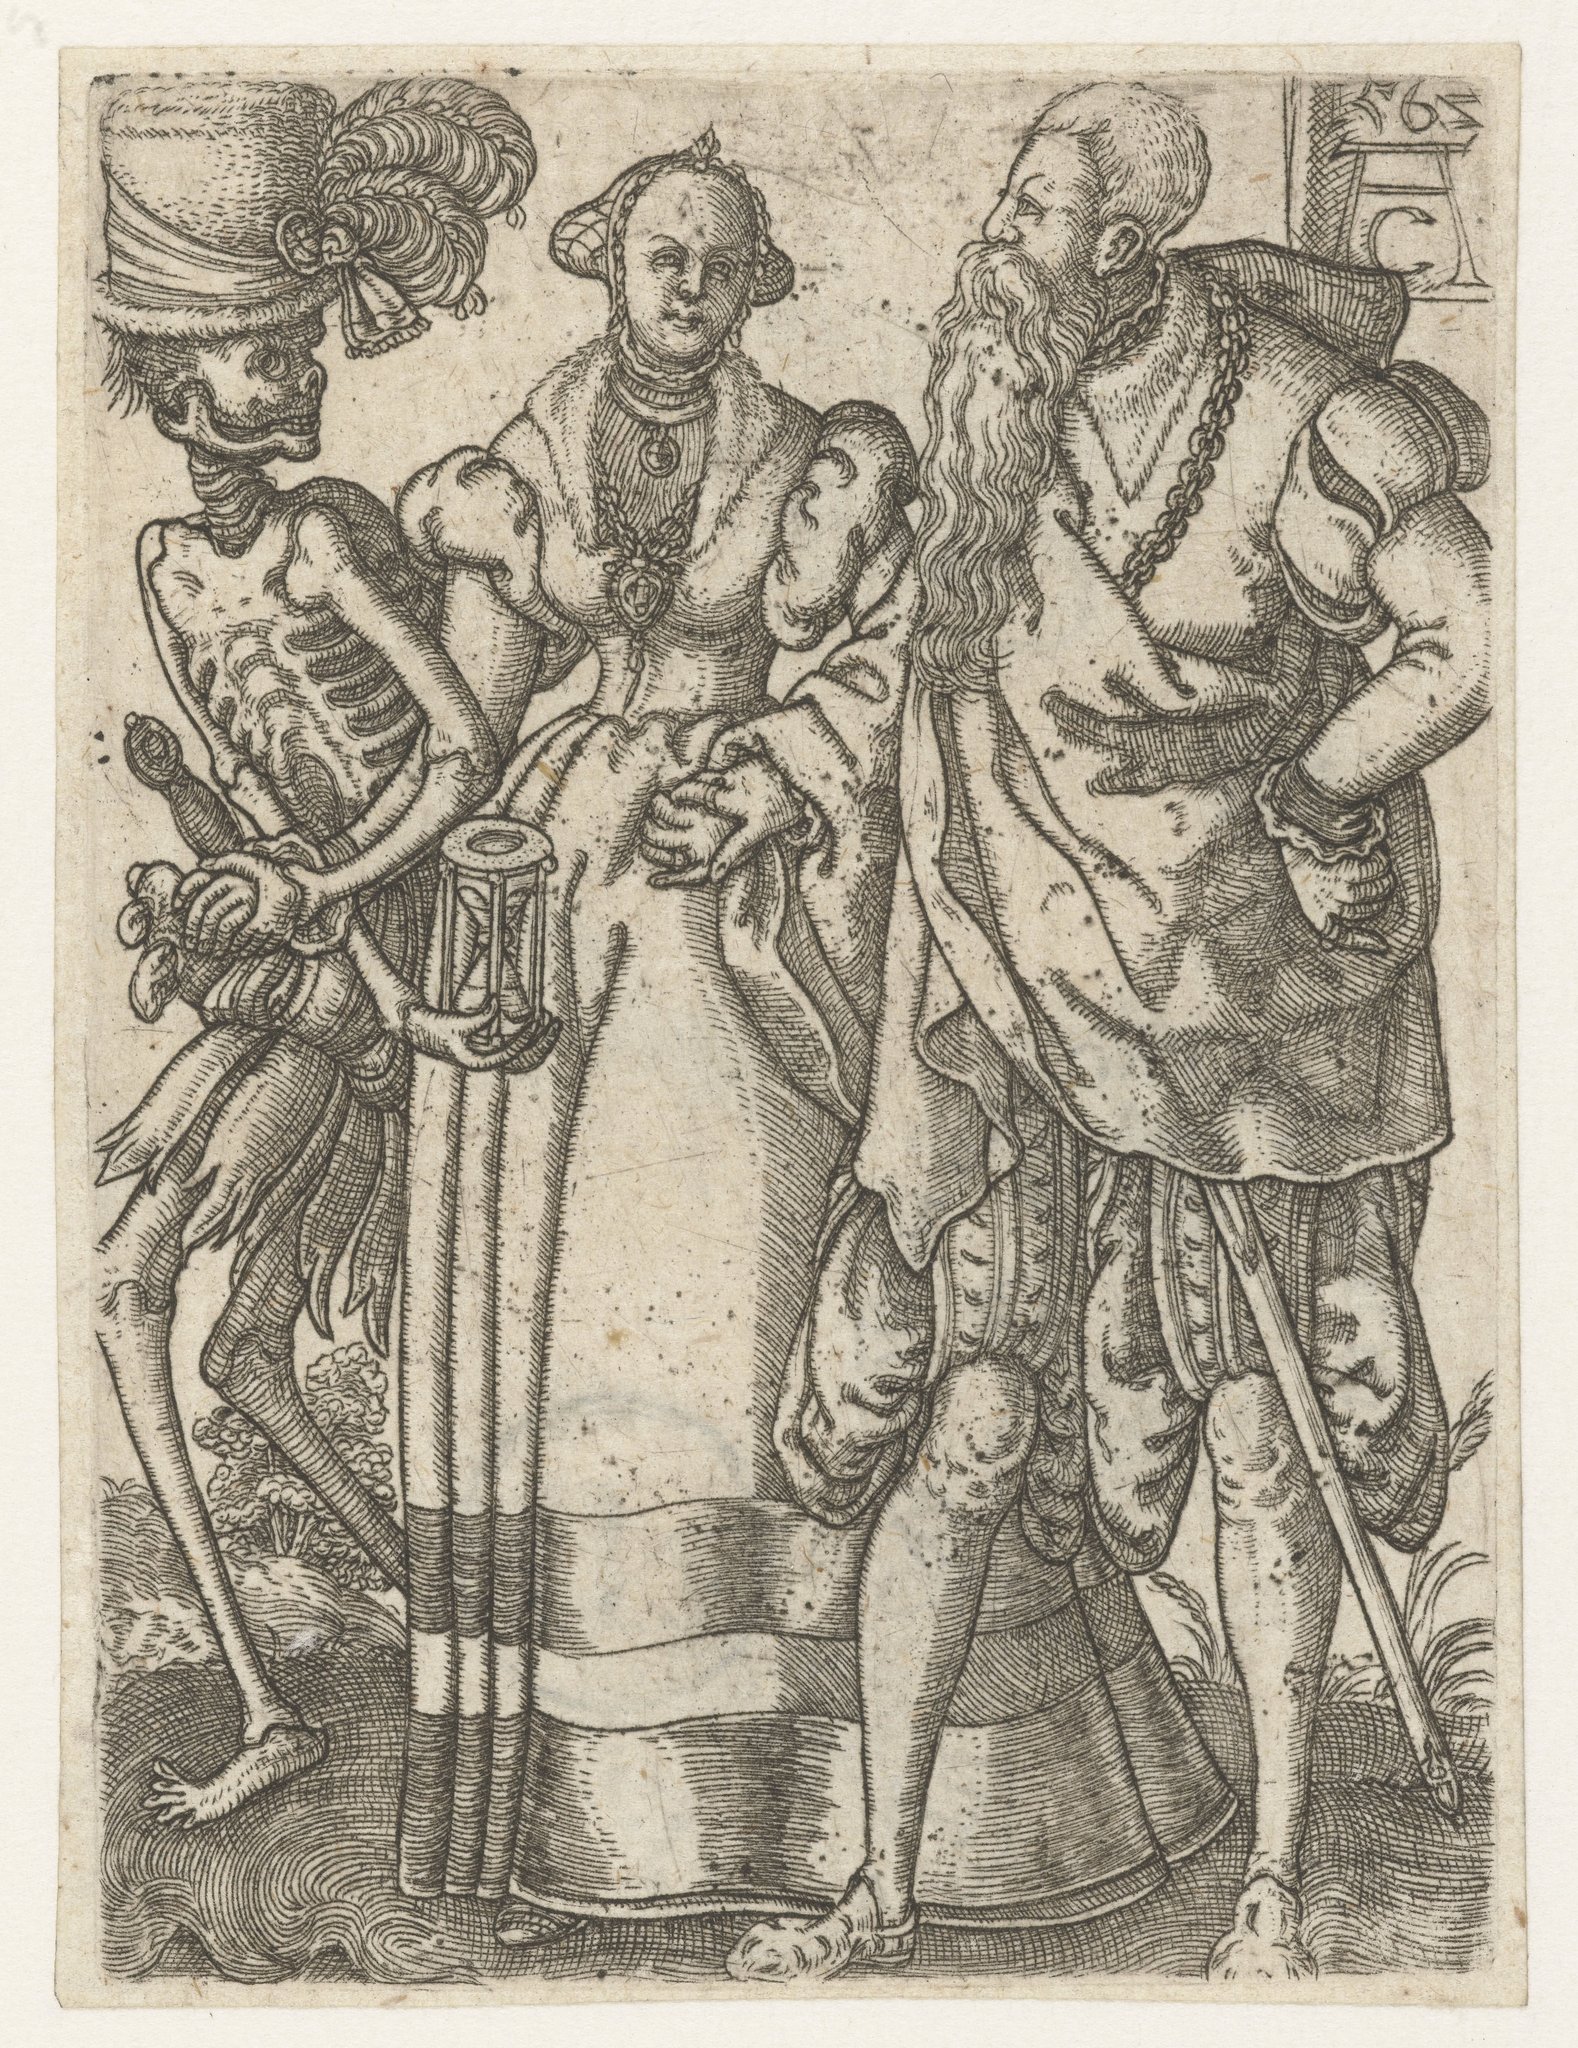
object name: print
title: Echtpaar met de Dood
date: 1562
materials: paper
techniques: engraving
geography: low countries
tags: dance of death; death together with one or more human beings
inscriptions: collector's mark: Lugt 2773, collector's mark: 2510, collector's mark: Lugt 2398, collector's mark: Lugt 1606, collector's mark: Lugt 2228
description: Prent uit serie van zeven. Echtpaar wordt aan de hand genomen door de Dood met hoge hoed.